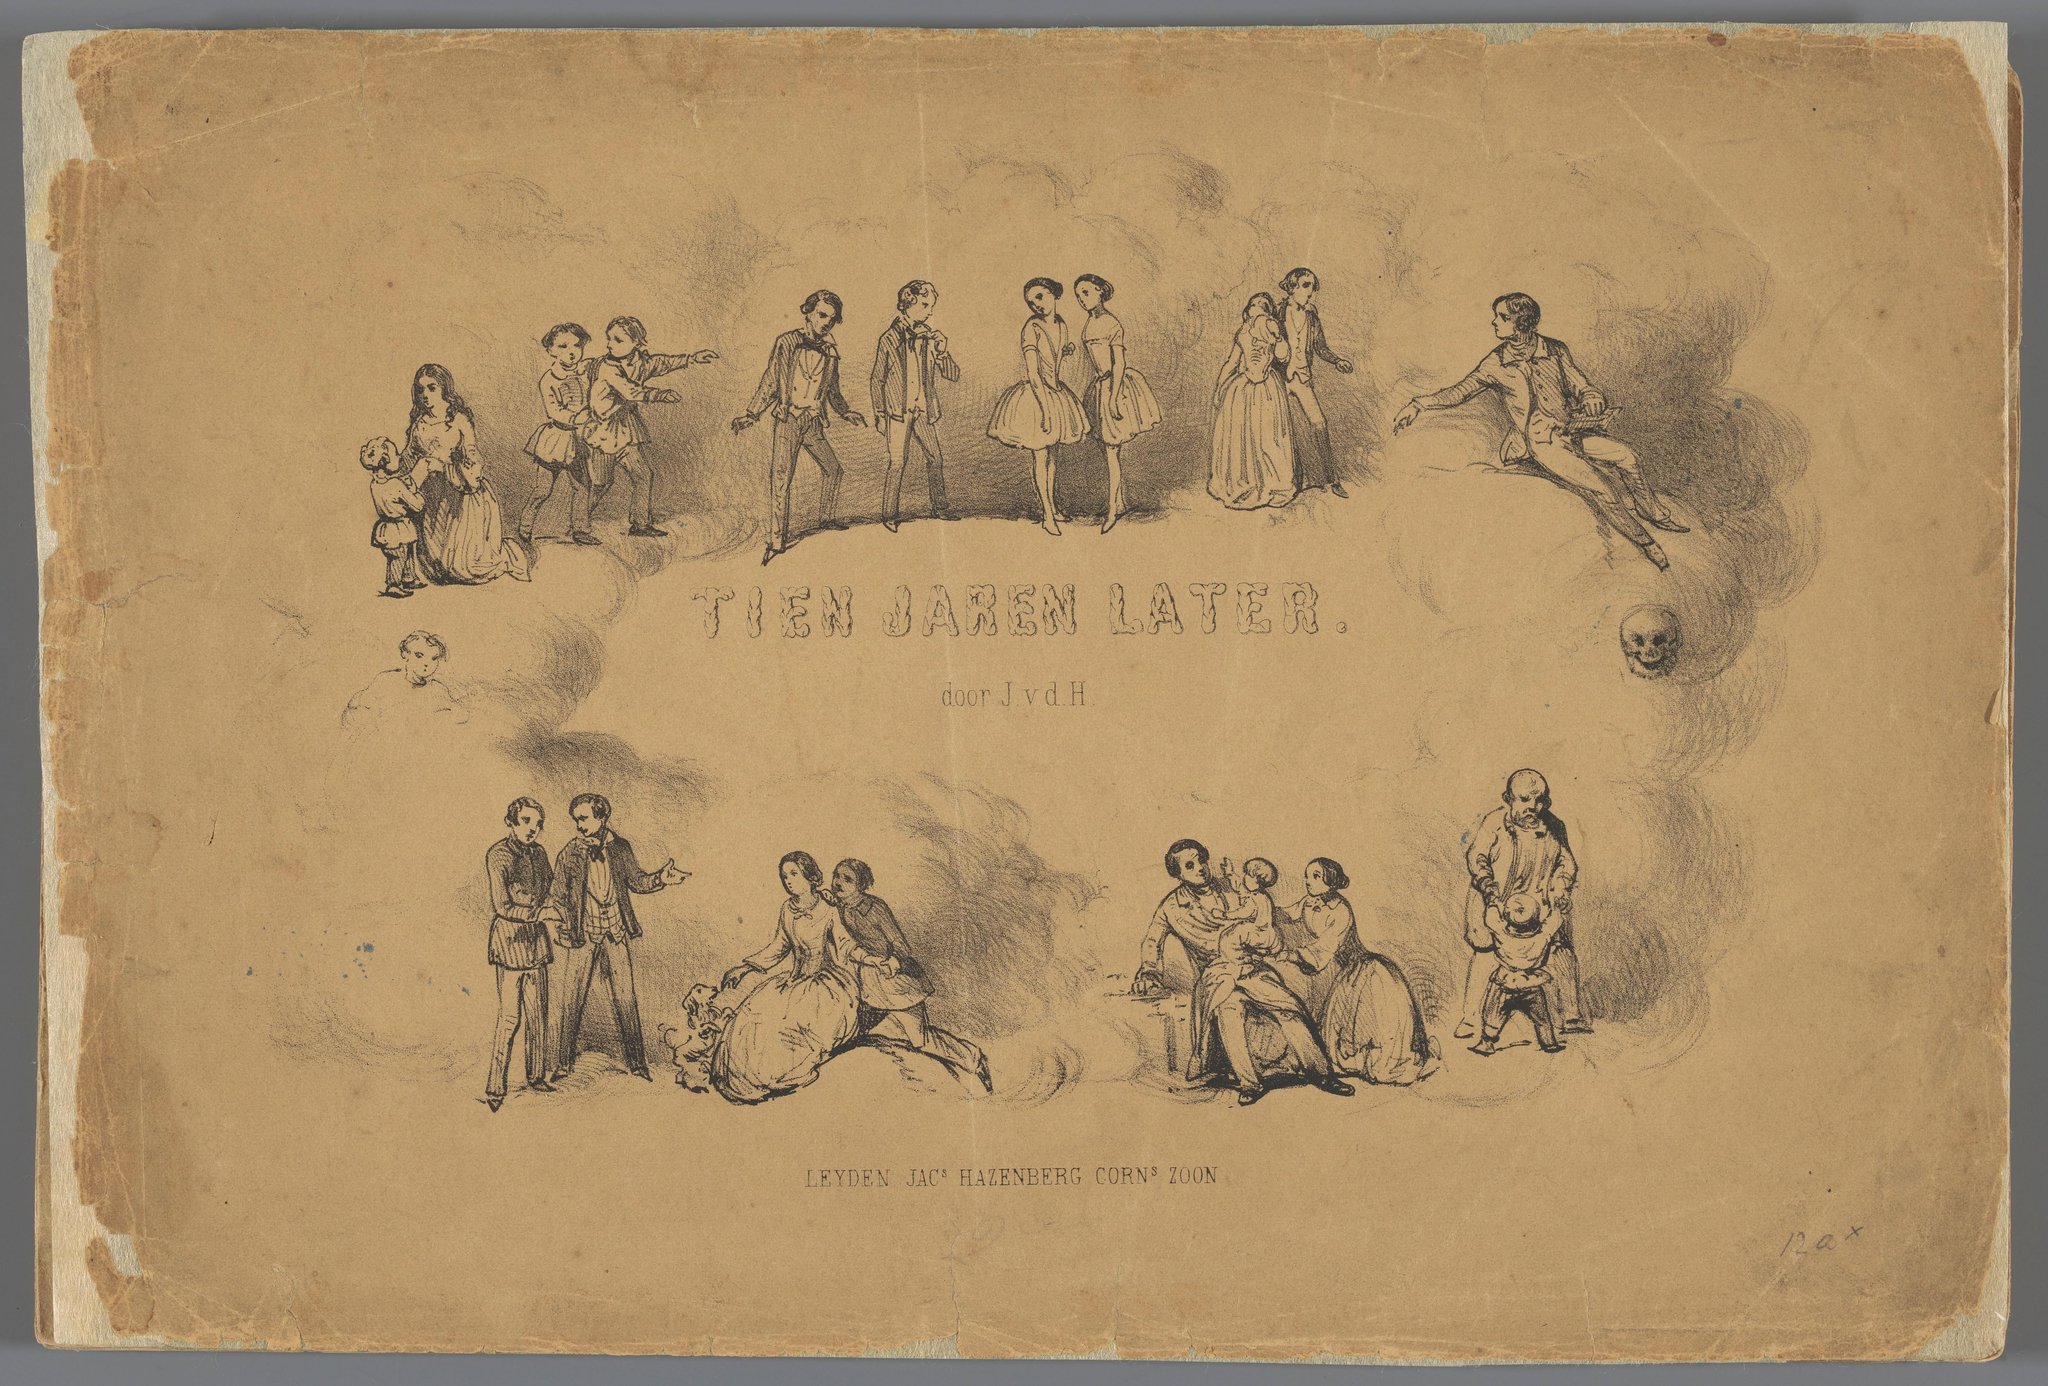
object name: wrapper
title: Tien jaren later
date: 1818-1876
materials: paper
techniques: lithograph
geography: leiden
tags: human life and its ages (young, adult, old, etc.), child, old man, skull as symbol of 'vanitas', couple of lovers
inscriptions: inscription: ‘Graven[...]’, collector's mark: Lugt 2228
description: De serie met omslag werd samengesteld door Jan van der Hoeven (Leiden 1834 - Rotterdam 1900). Van der Hoeven was mede oprichter van het Sophia-Kinderziekenhuis in Rotterdam en was als heelmeester verbonden aan het stedelijk ziekenhuis aldaar.